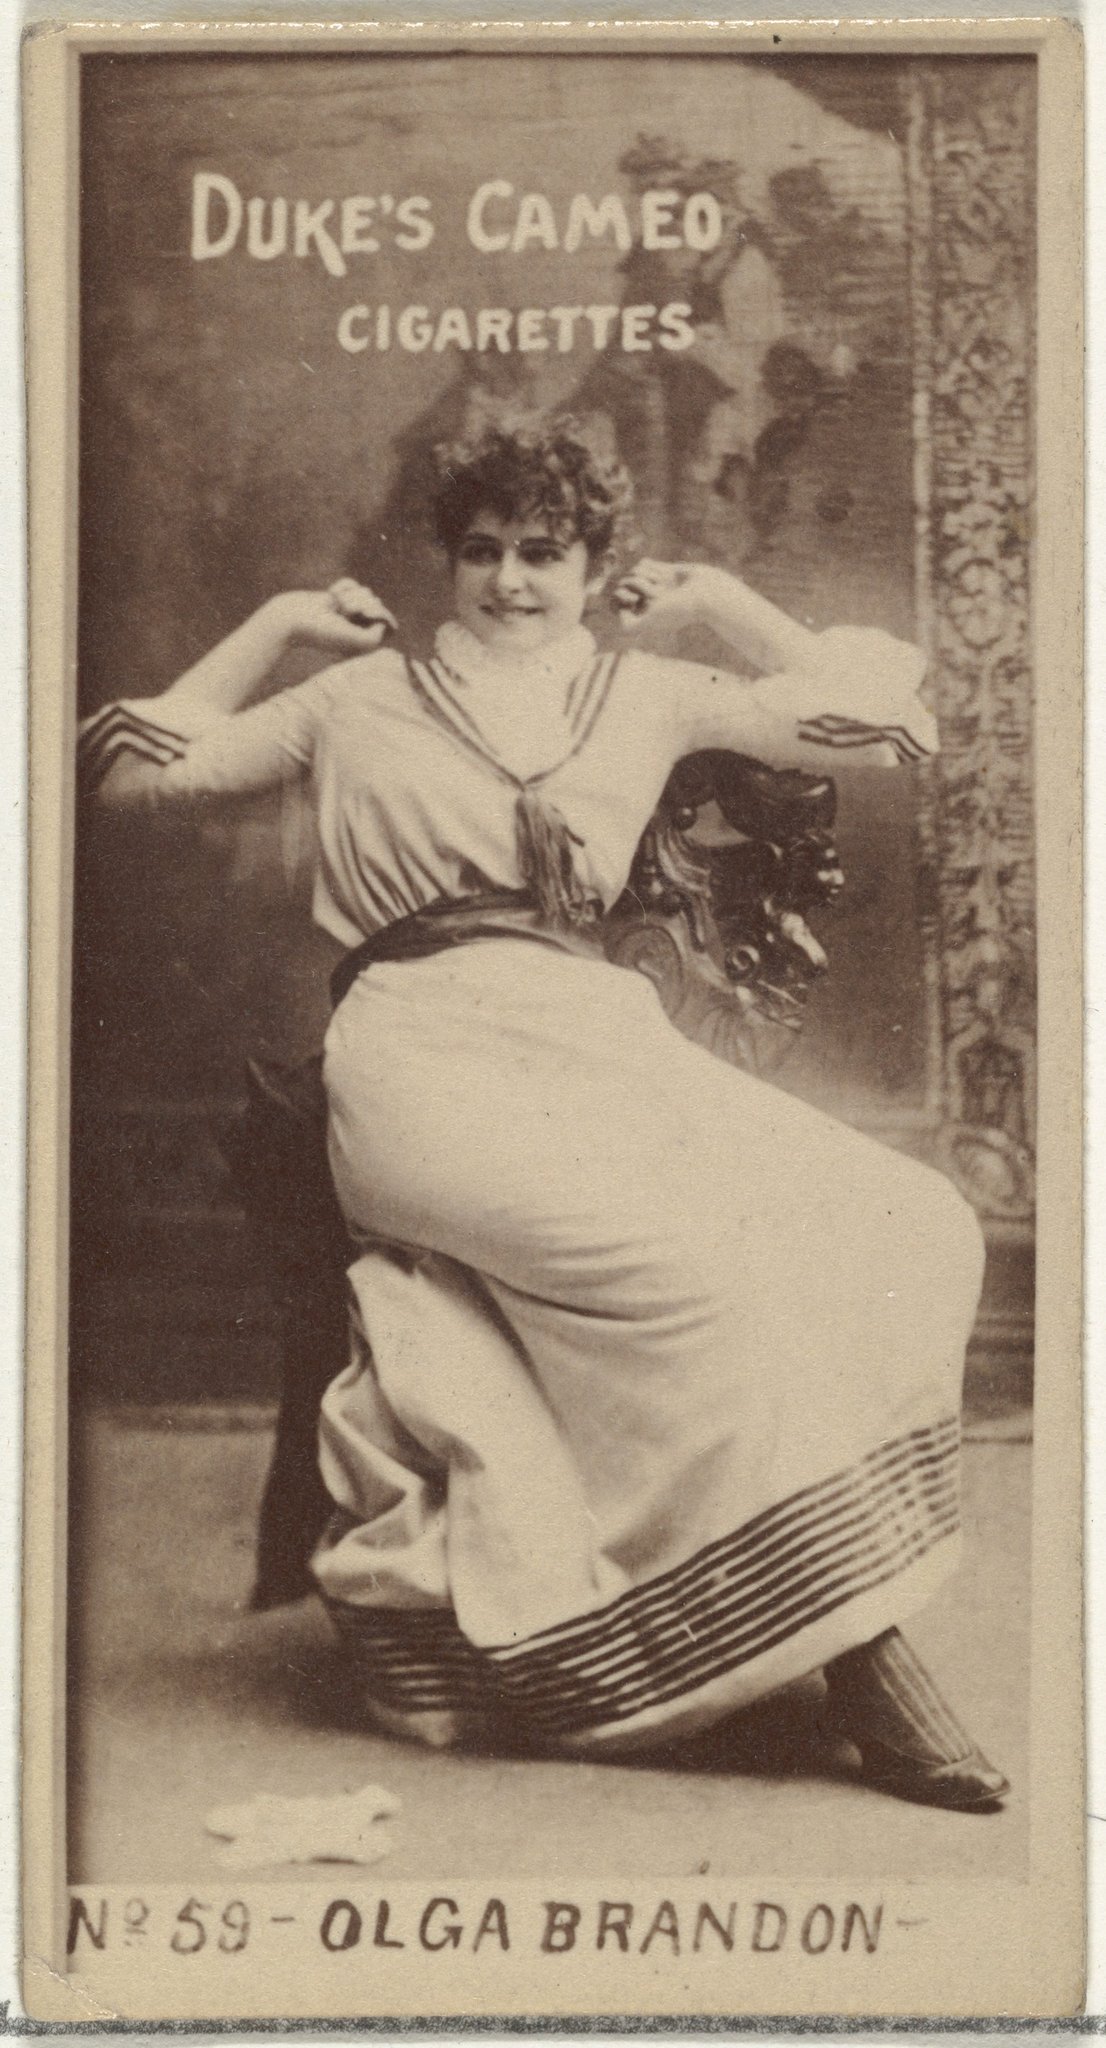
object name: photograph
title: Card Number 59, Olga Brandon, from the Actors and Actresses series (N145-4) issued by Duke Sons & Co. to promote Cameo Cigarettes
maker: w. duke, sons & co.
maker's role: publisher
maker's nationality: american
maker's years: 1870-1920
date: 1880-1889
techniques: albumen silver print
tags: portraits,women,actresses